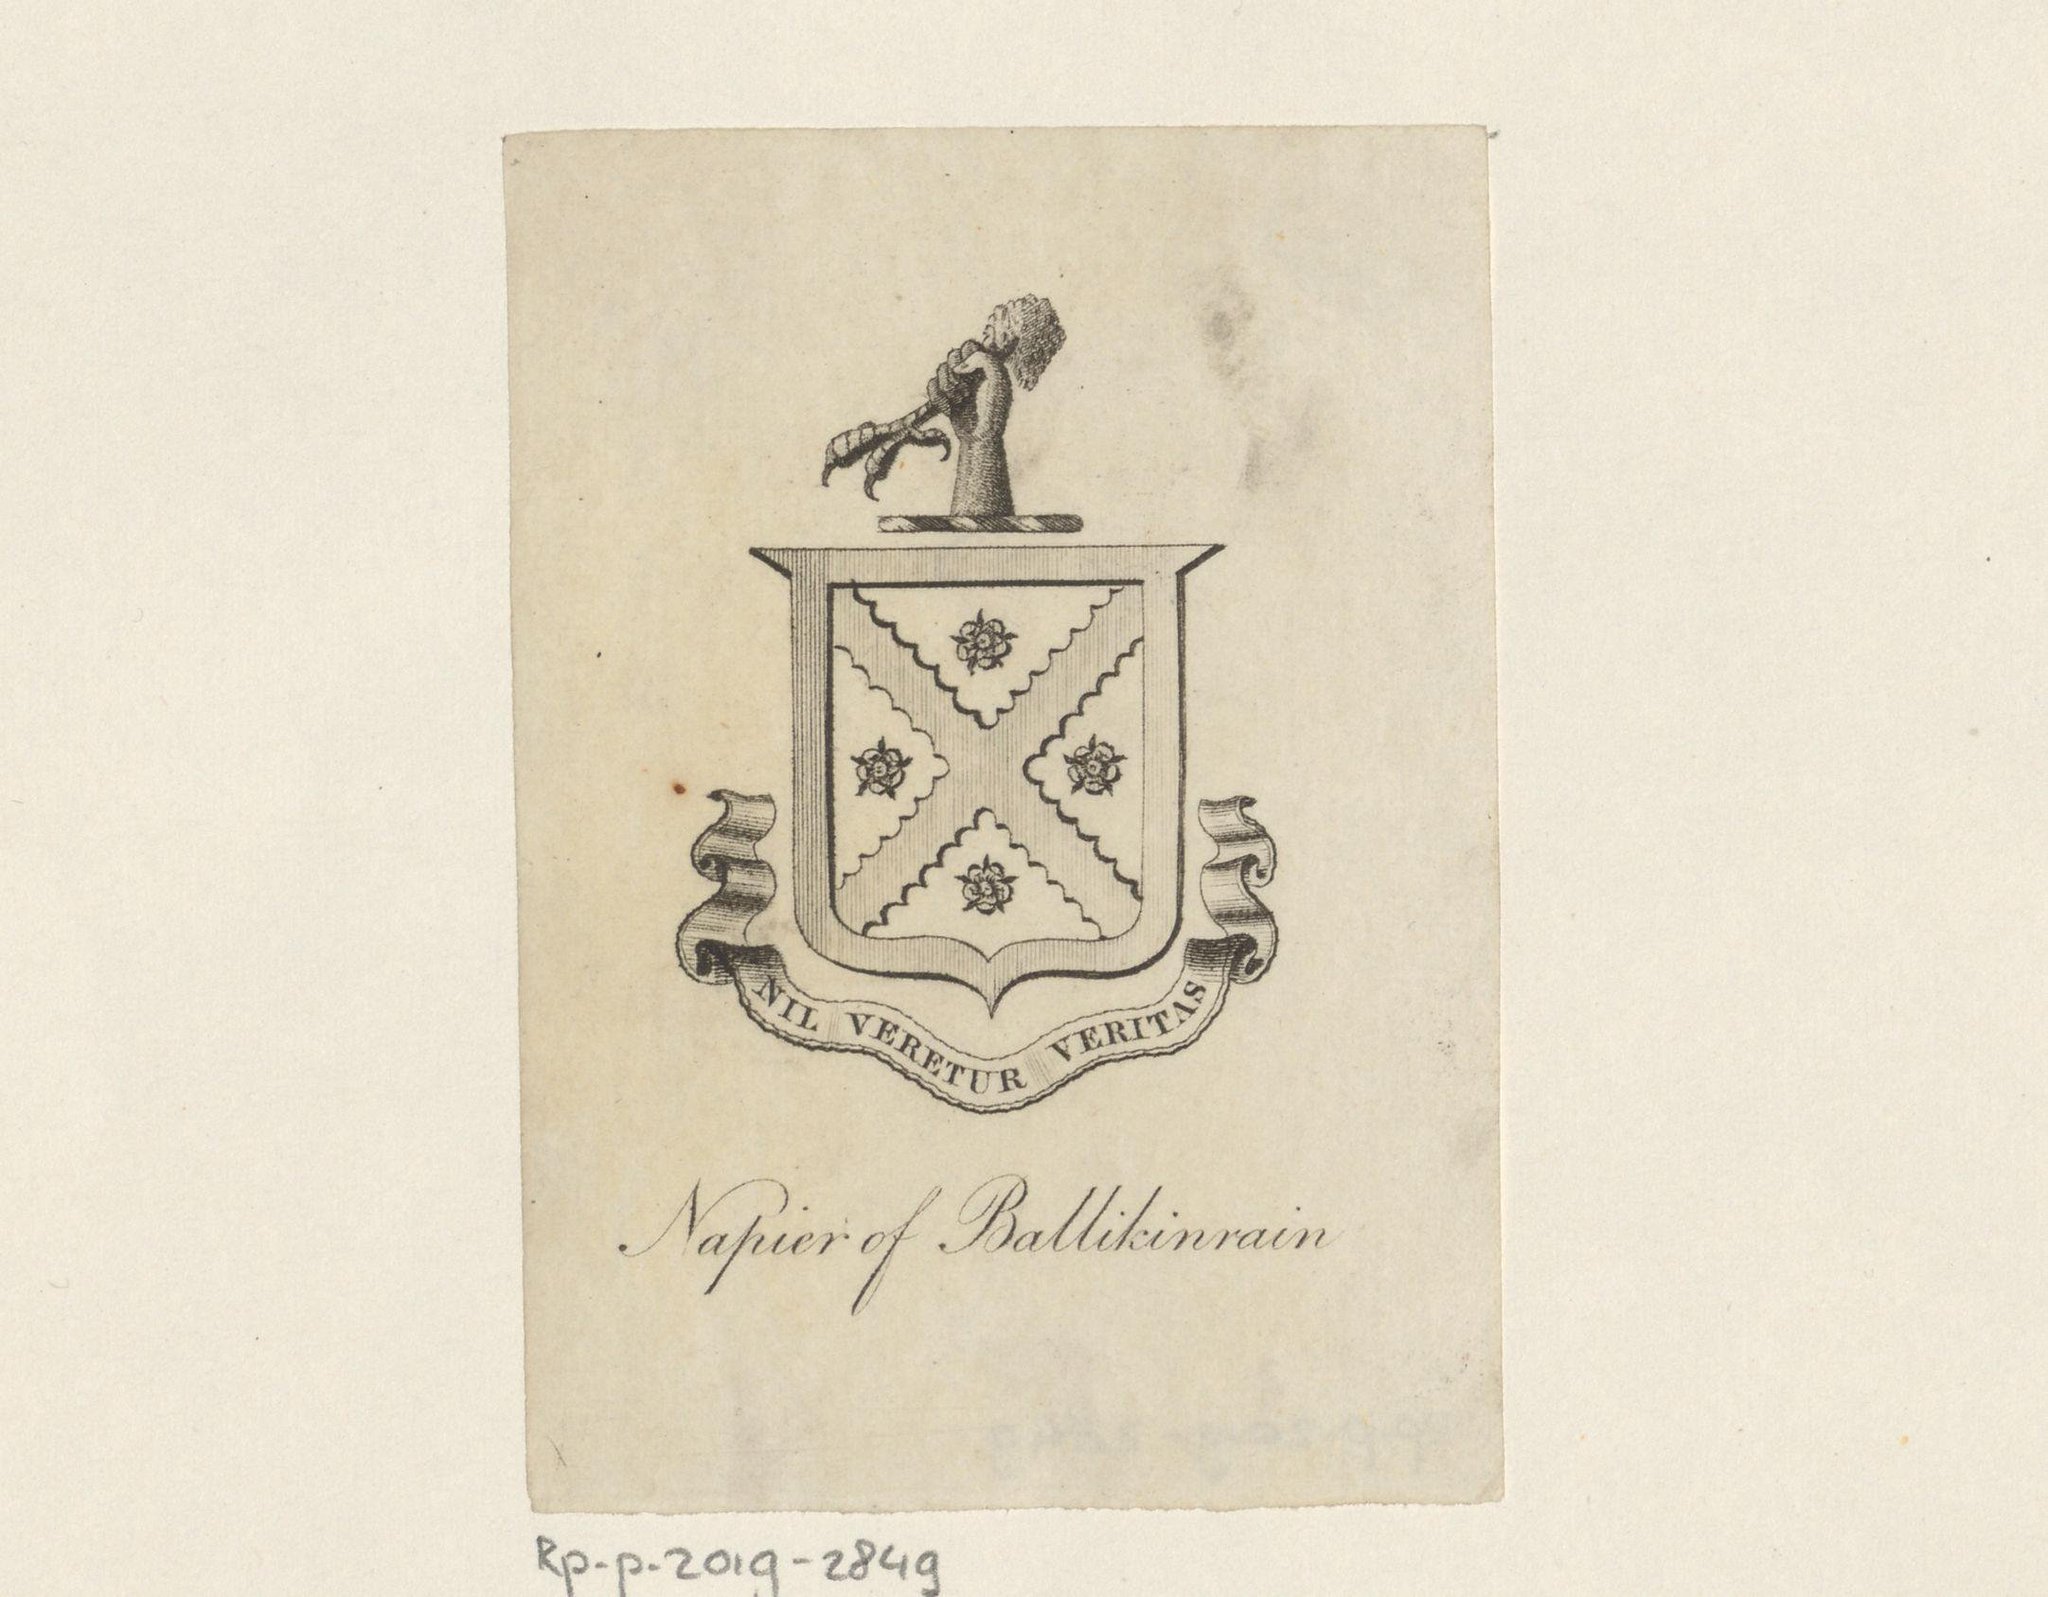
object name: bookplate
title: Nil veretur veritas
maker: Anonymous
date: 1800-1899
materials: paper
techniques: engraving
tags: armorial bearing, heraldry